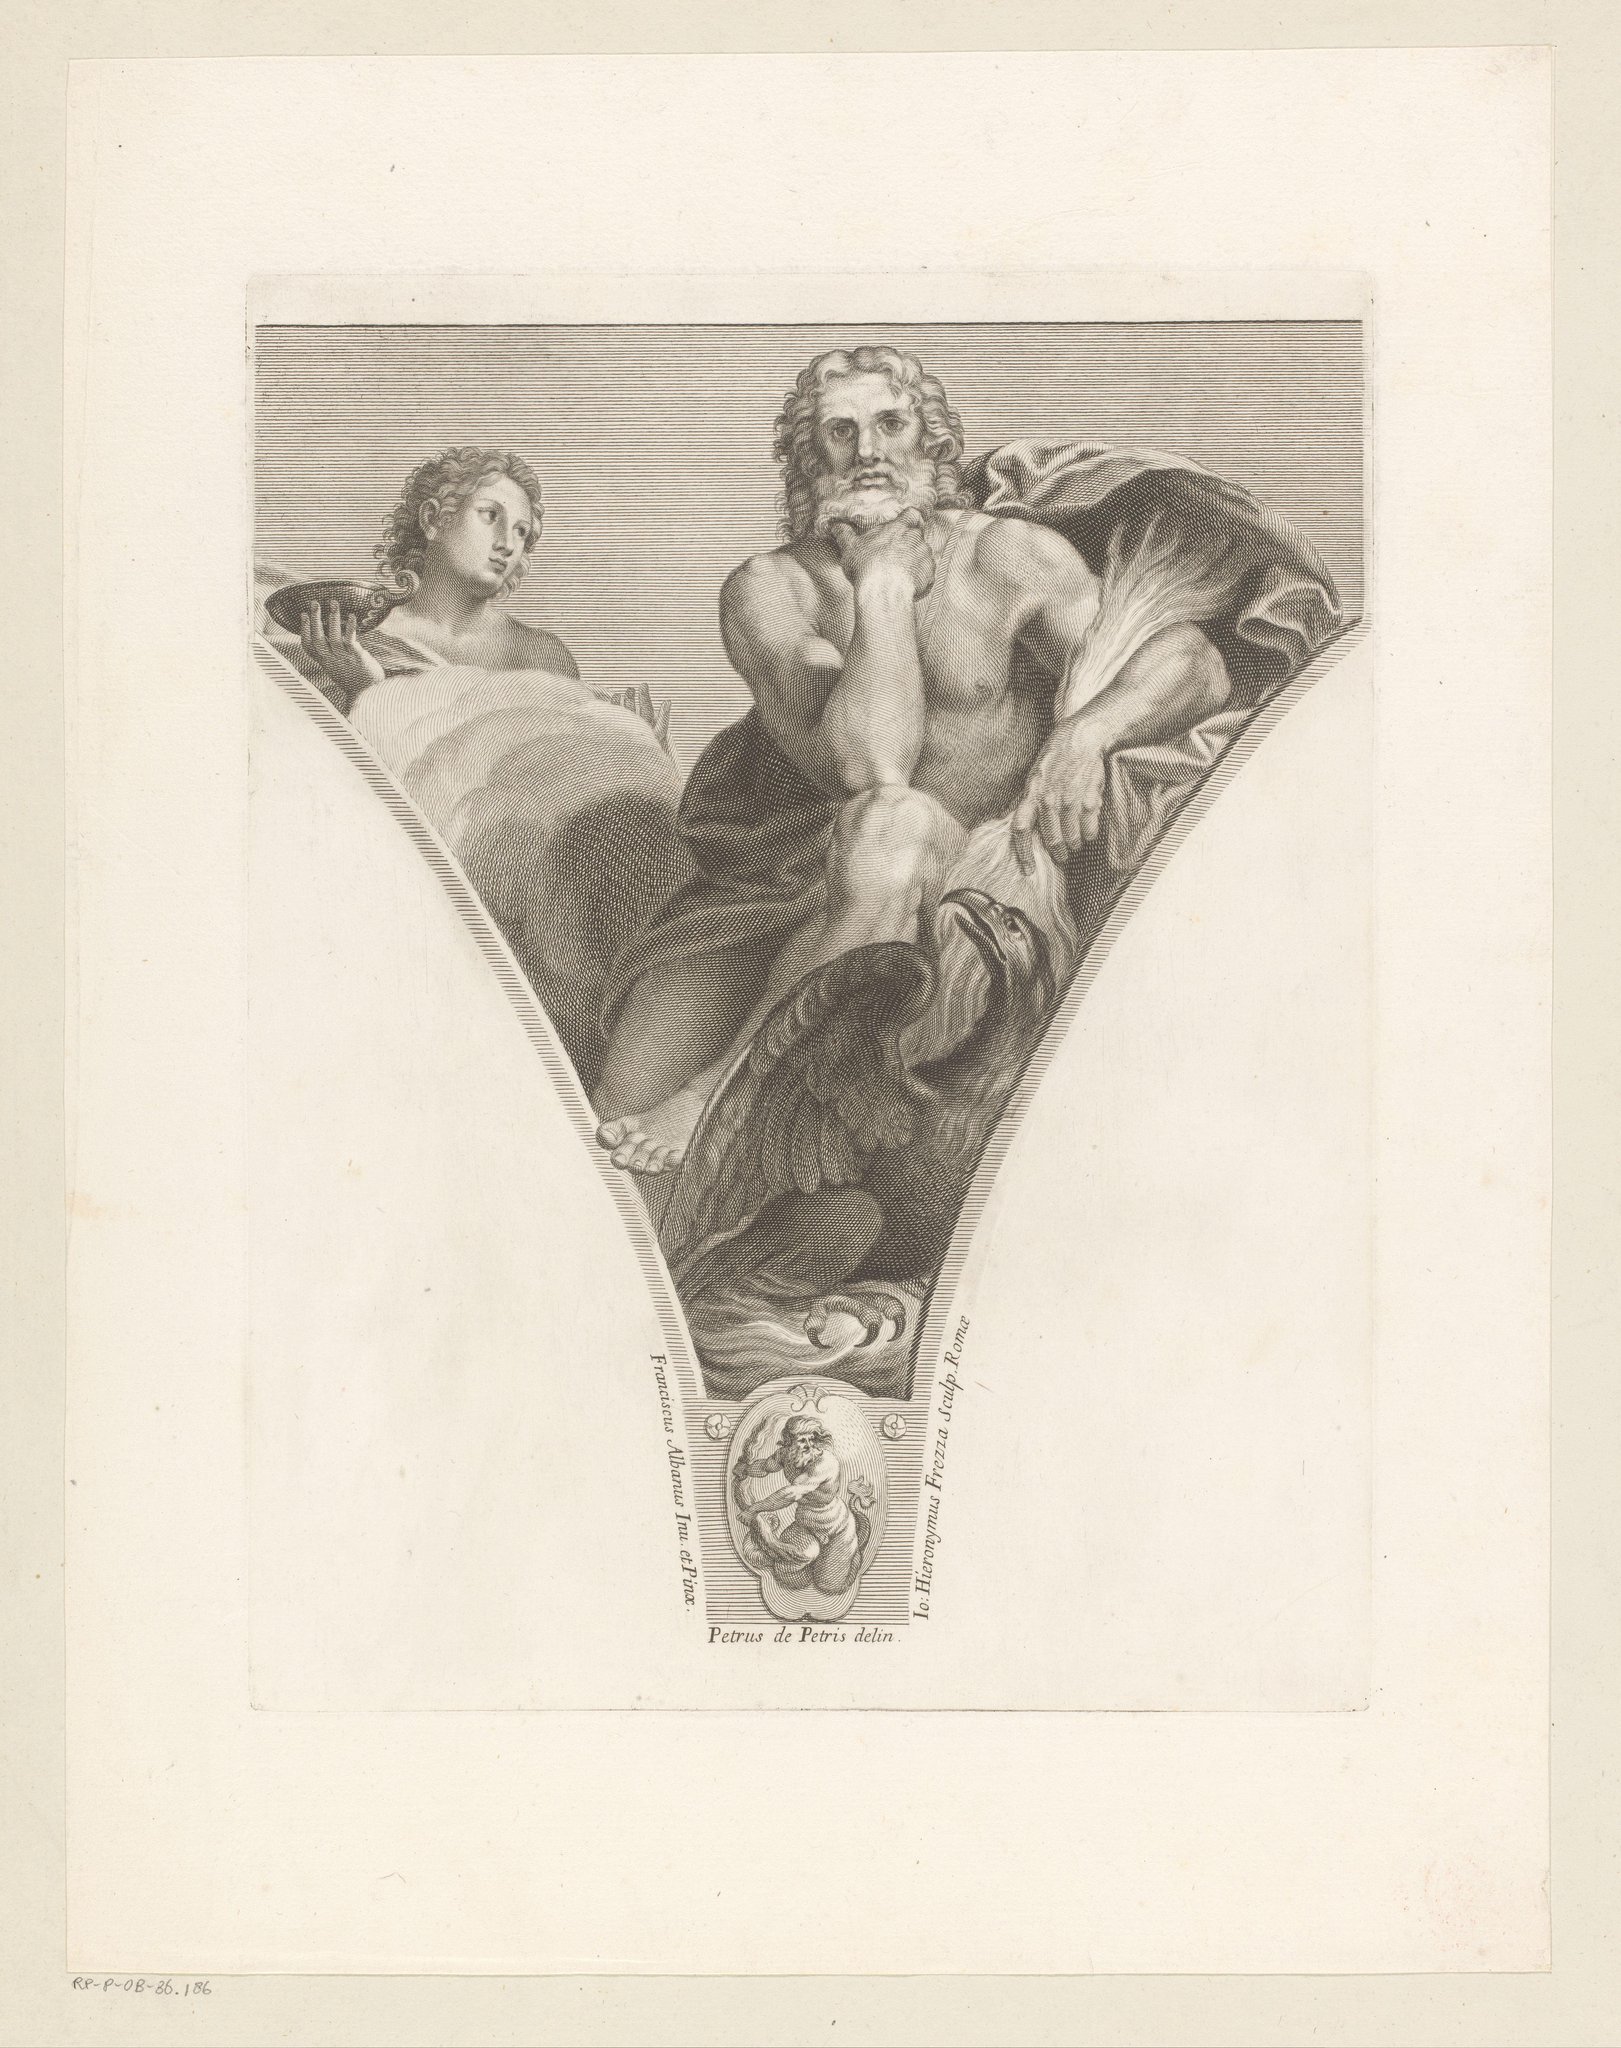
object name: print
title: Schilderingen door Francesco Albani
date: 1704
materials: paper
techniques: engraving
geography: italy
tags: (story of) jupiter (zeus)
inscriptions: collector's mark: Lugt 240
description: De god Jupiter met bliksemschichten en zijn adelaar. Decoratie van een pendentief.